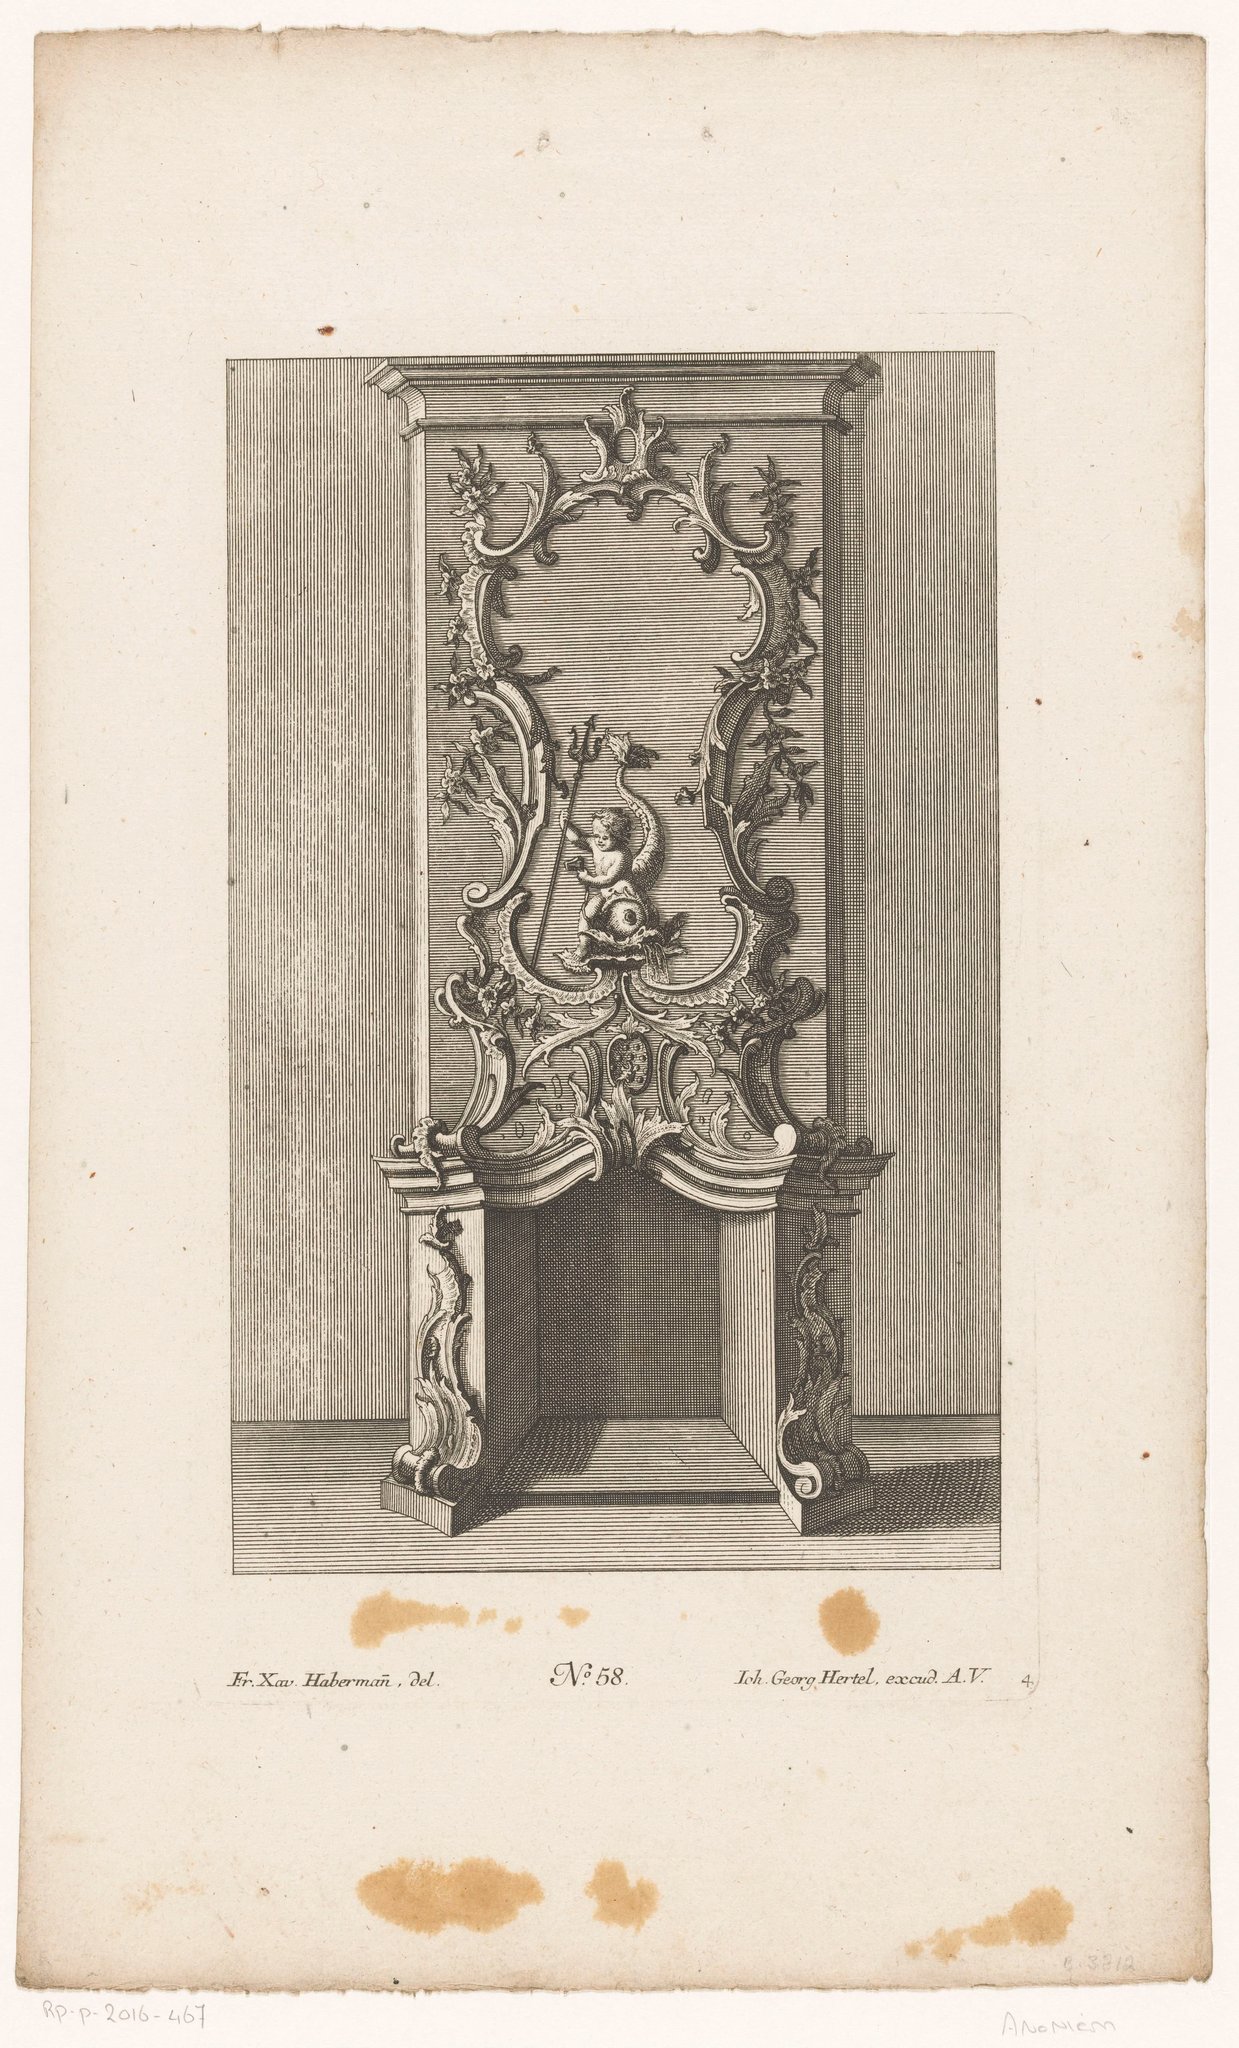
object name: print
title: Schouw met putto op zeewezen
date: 1731-1775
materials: paper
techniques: engraving, etching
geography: augsburg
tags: rocaille ornament, burning as process, cupids: 'amores', 'amoretti', 'putti'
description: Rocaille schouw met putto met een drietand op een zeewezen. Uitgeversnummer 58.